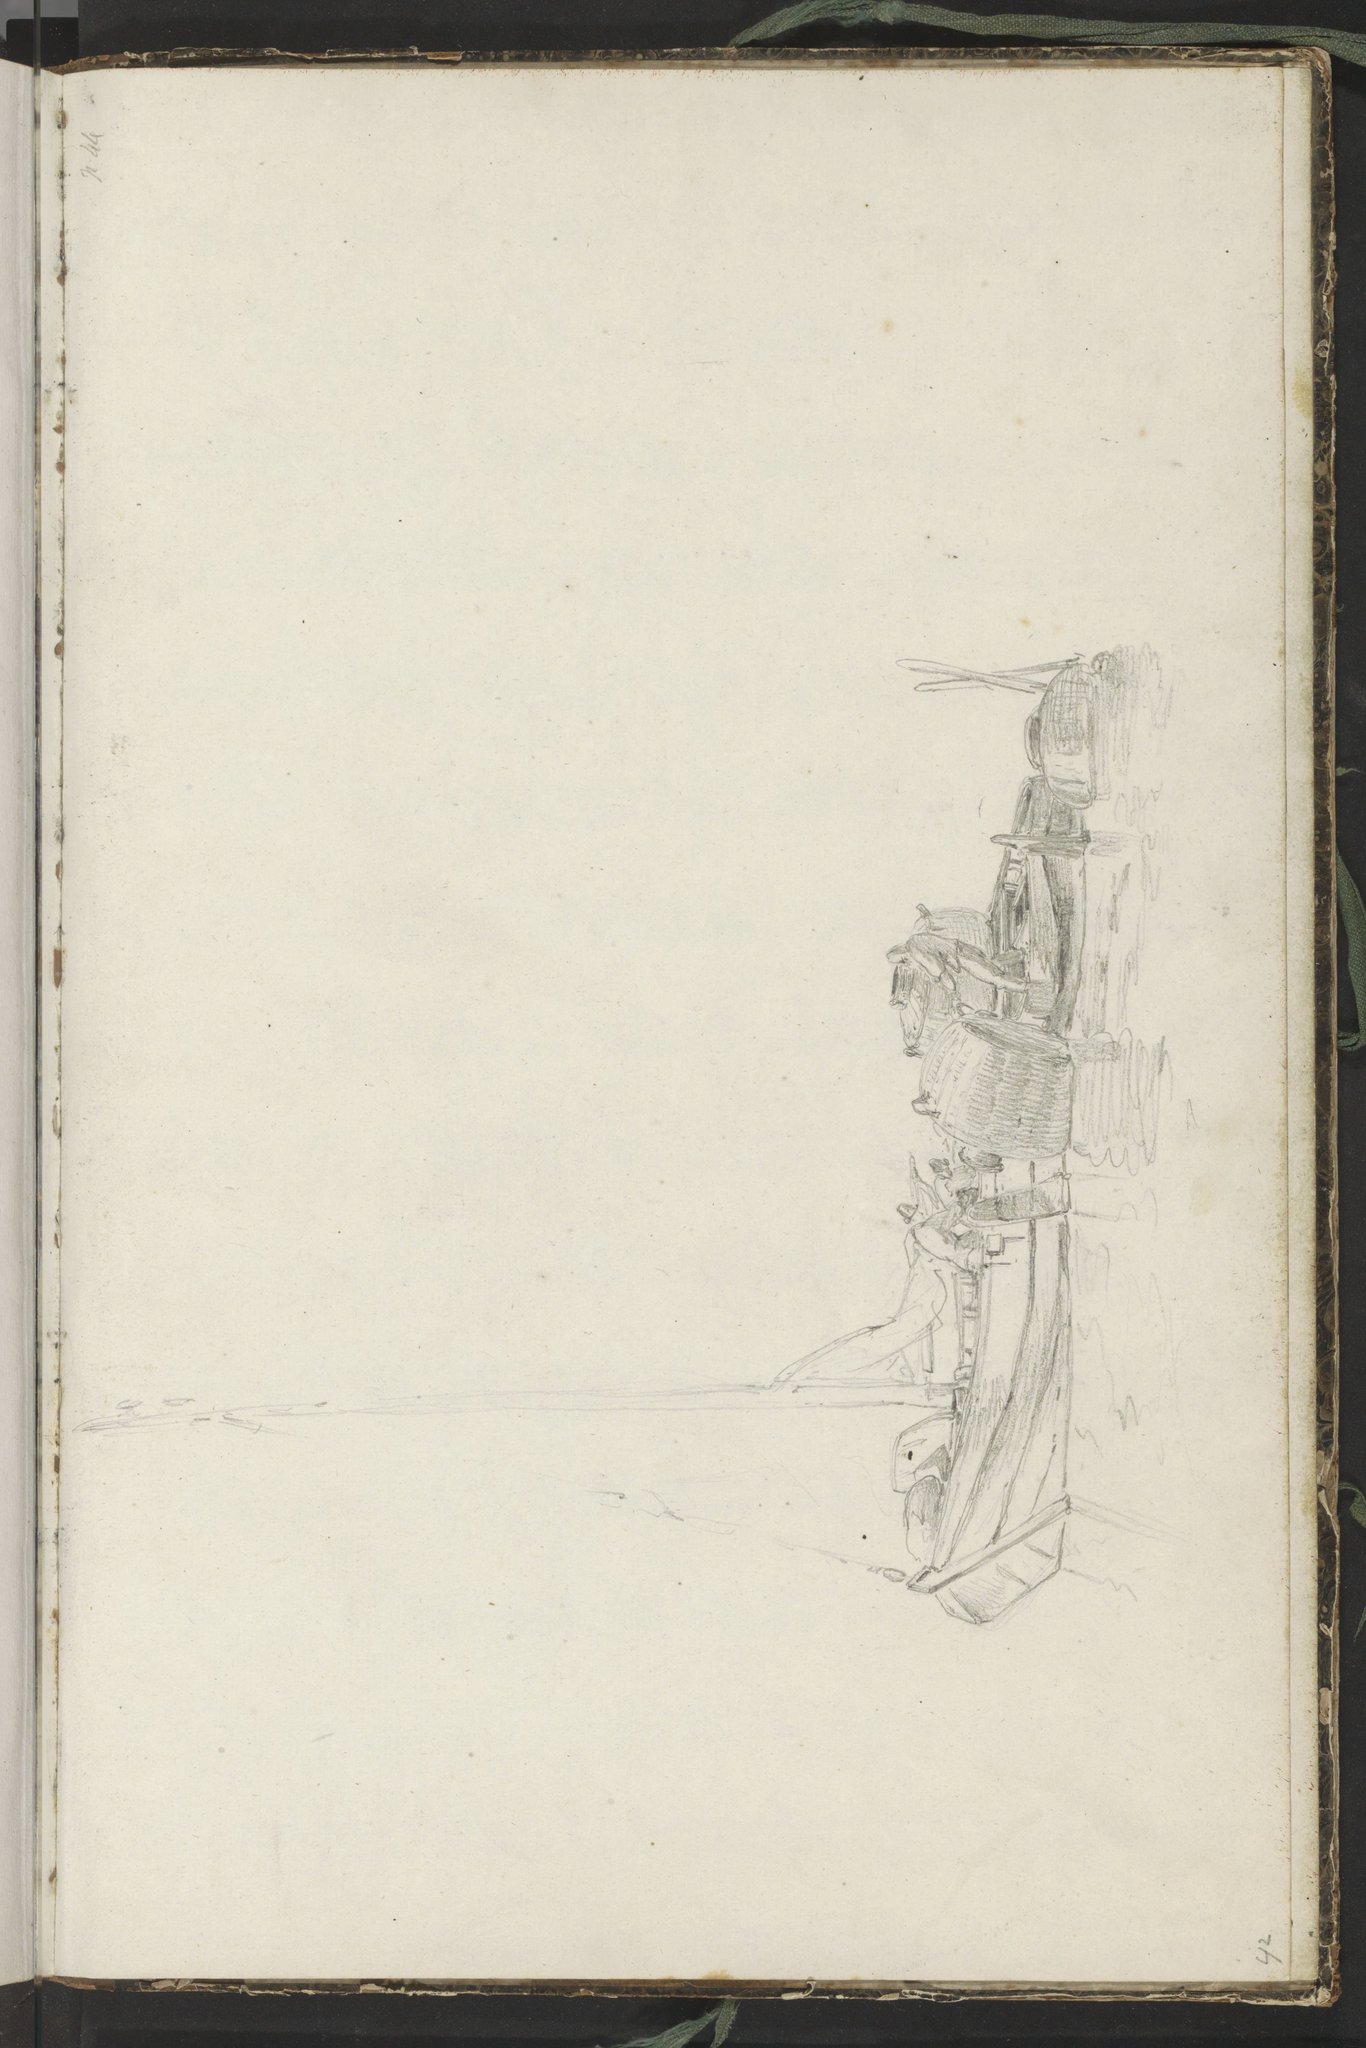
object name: sketchbook leaf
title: Lossen van een lading uit een schip bij een kade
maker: johannes christiaan schotel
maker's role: draughtsman, painter, print maker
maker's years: 1787-1838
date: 1797-1838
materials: paper, pencil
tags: sailing-ship, sailing-boat, freight vessel, pier, quay, wharf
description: Blad 42 recto uit een schetsboek met 44 bladen.